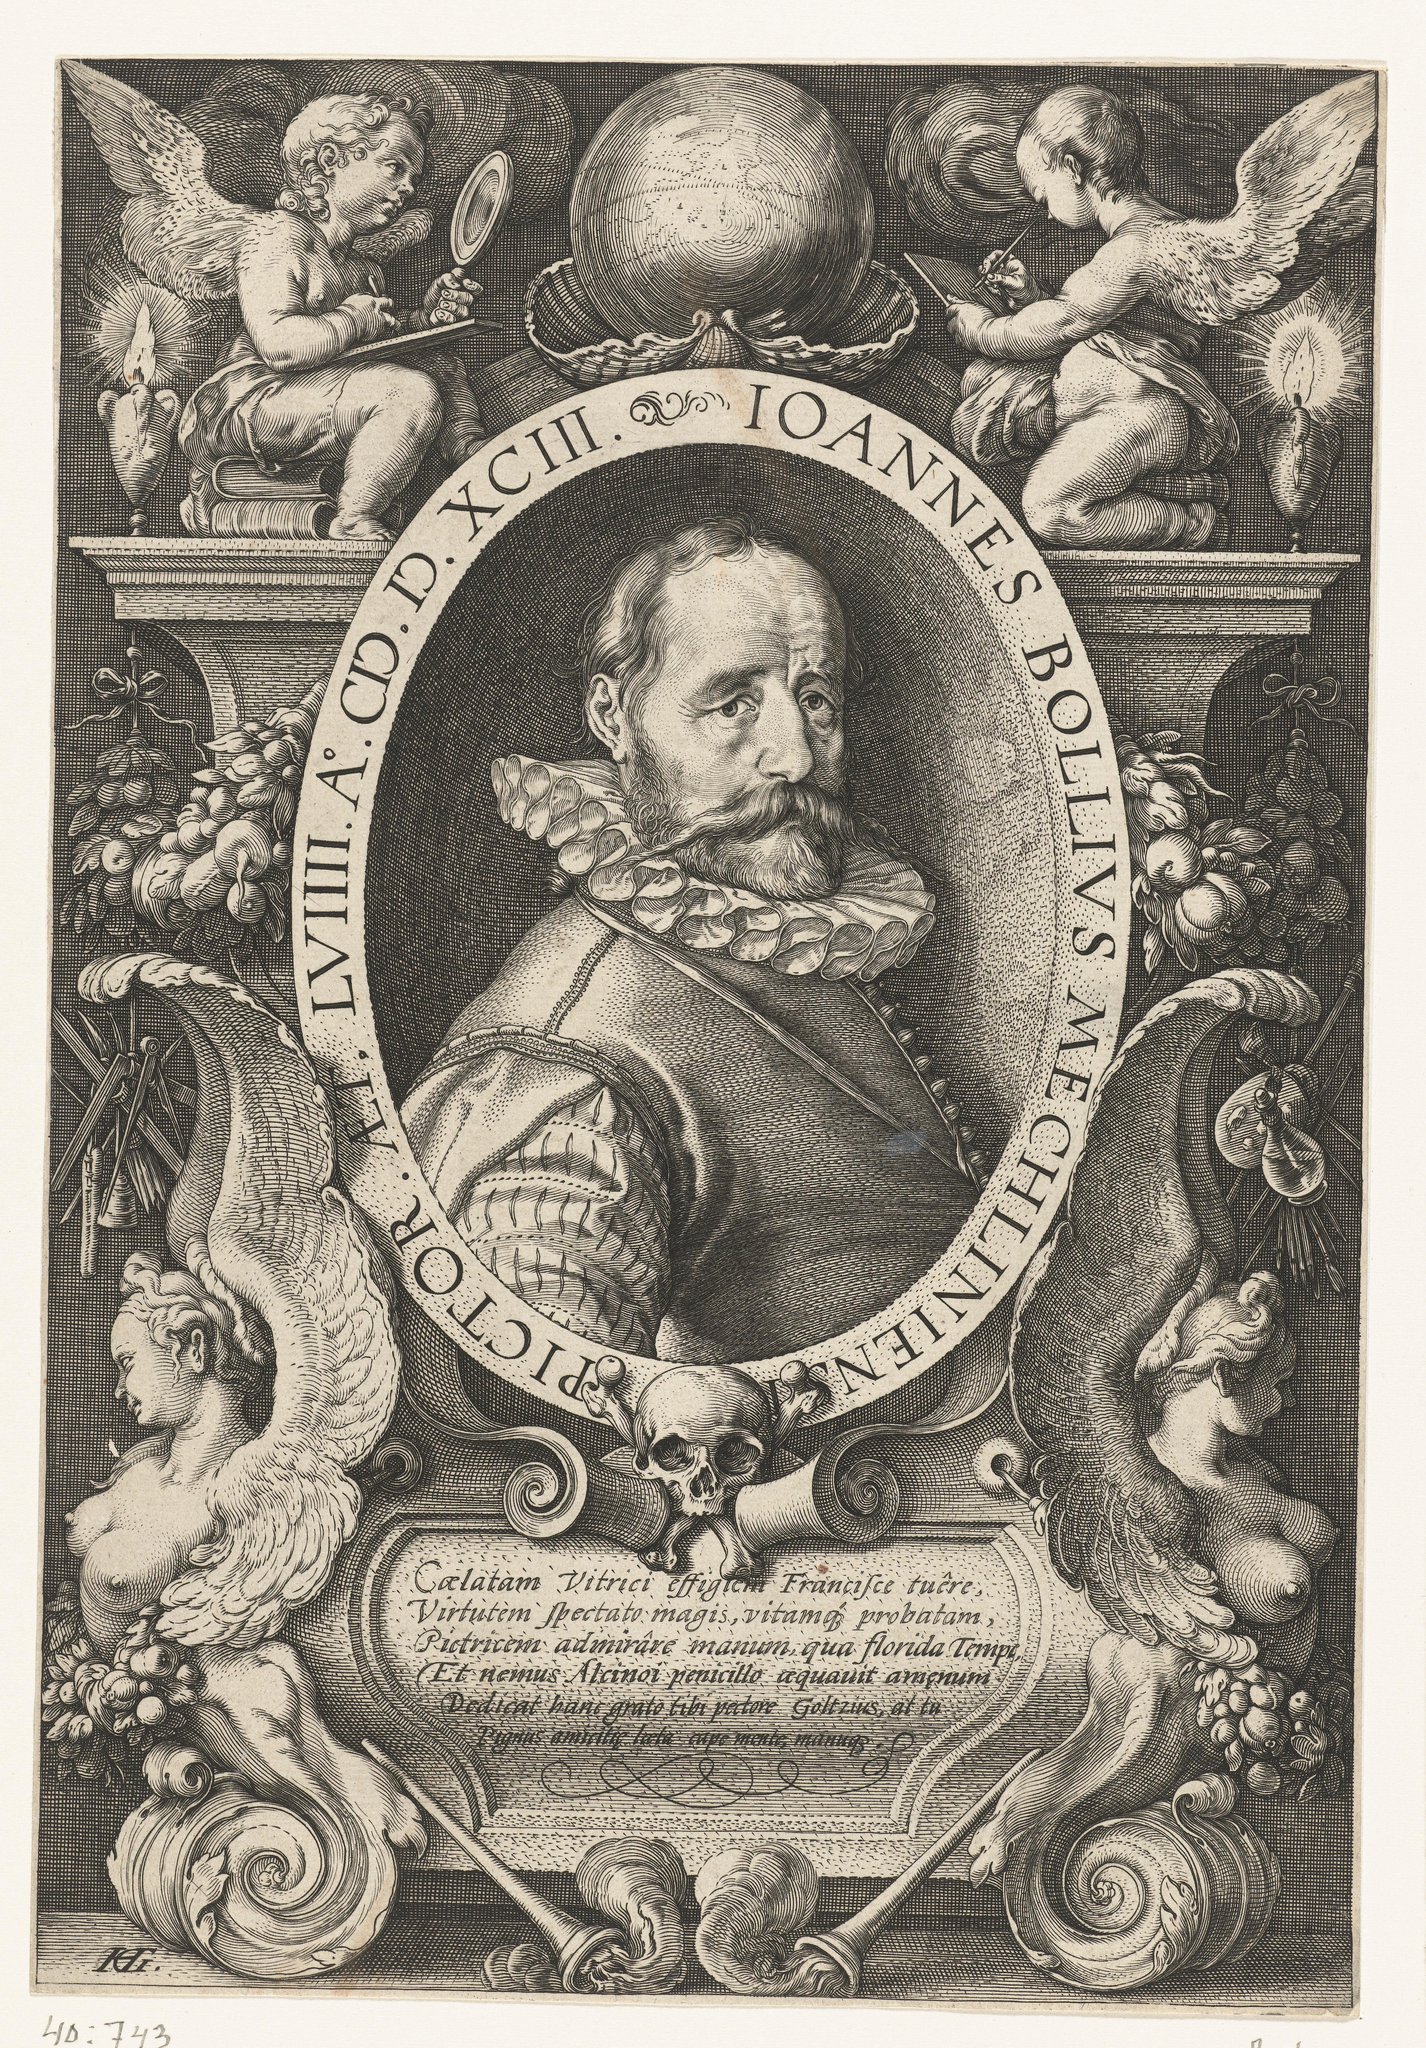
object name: print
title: Portret Hans Bol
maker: hendrick goltzius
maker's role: draughtsman, painter, print maker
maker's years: 1558-1617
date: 1593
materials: paper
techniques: engraving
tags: mechelen, amsterdam, hans bol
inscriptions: monogram: ‘HG.’, mark: ‘L.2760’, mark: ‘L.2228a’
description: ortret van Hans Bol (1534-1593), ten halven lijve, op de rechterzijde gezien, in ovaal afgebeeld, de blik naar voren gericht. Het ovaal is in een sokkel geplaatst; hieromheen verscheidene decoratieve elementen die verwijzen naar de dood en de werkzaamheden van Bol. Rondom in ovaal en op sokkel Latijnse teksten.